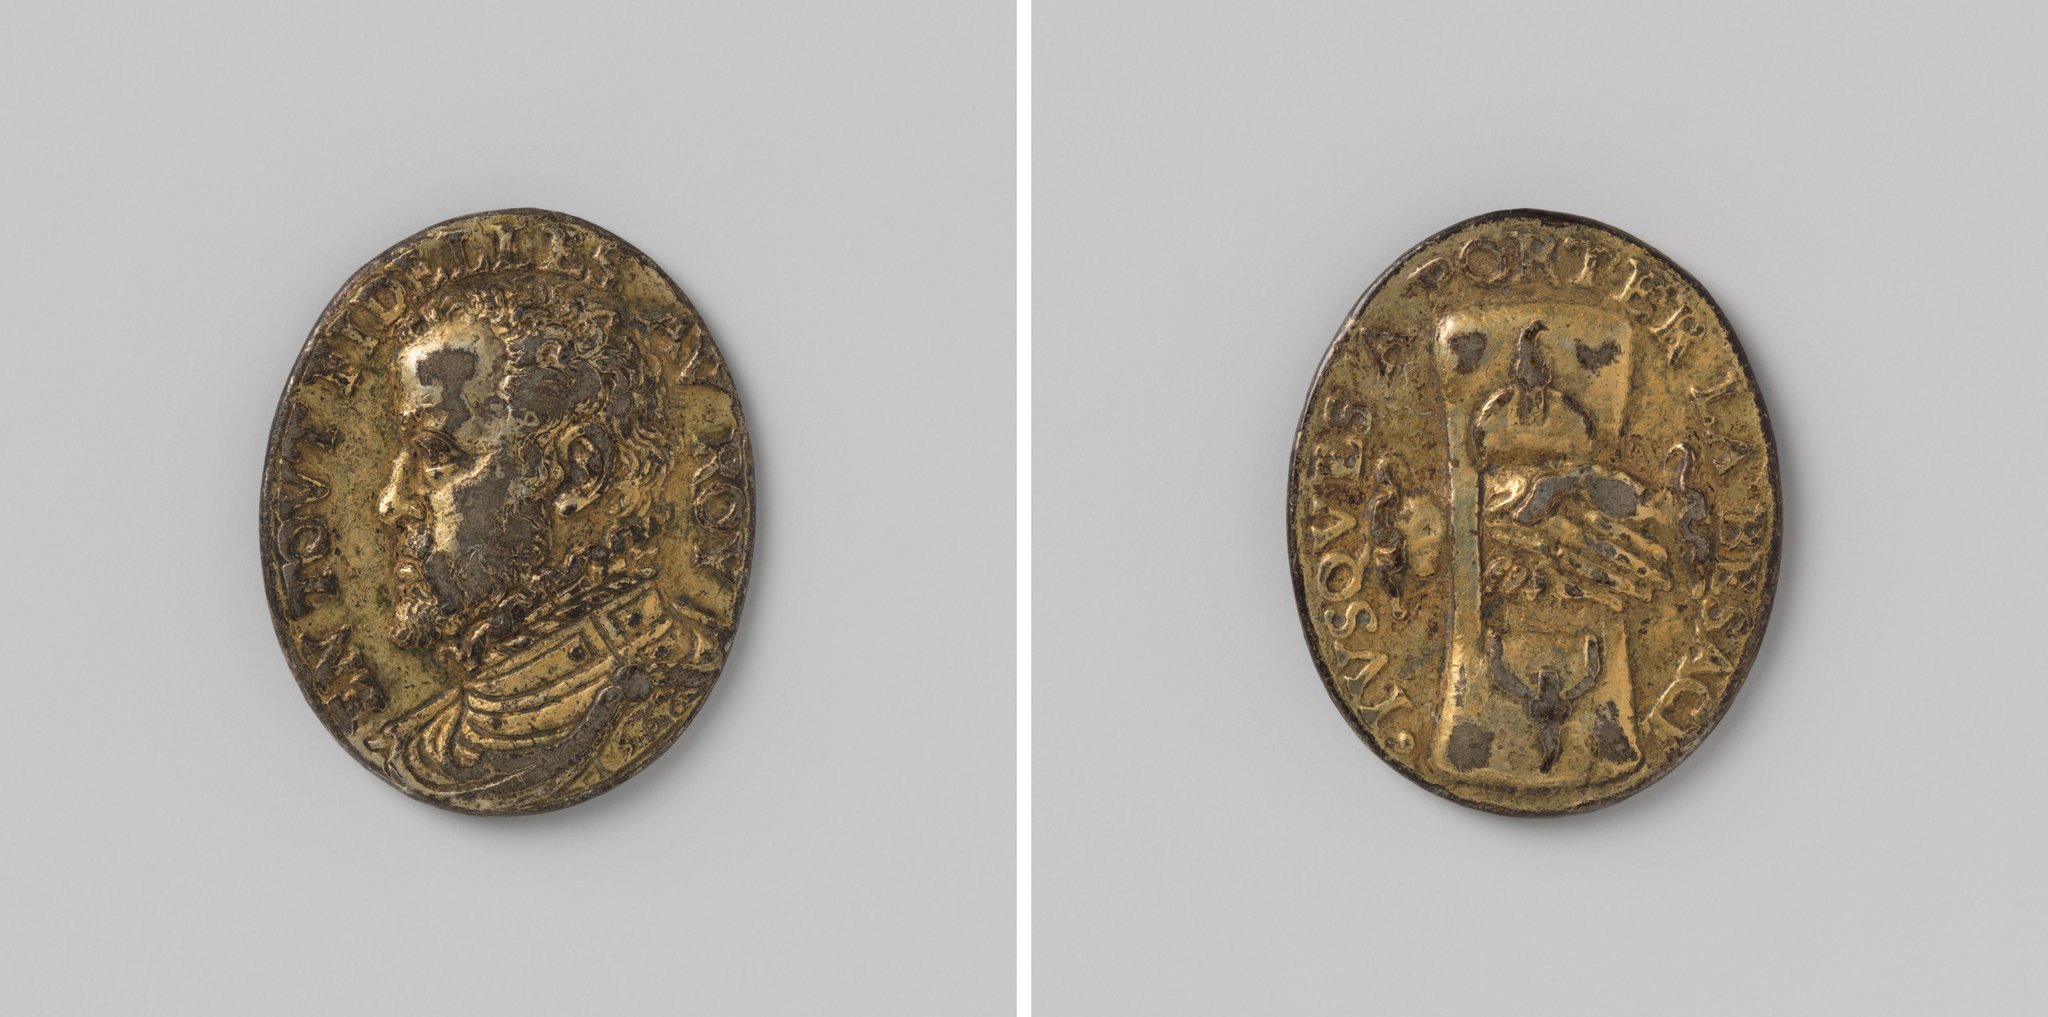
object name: insignia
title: Watergeuzen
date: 1566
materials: silver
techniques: casting, gilding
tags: philip ii of spain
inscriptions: circumscription: ‘EN TOVT FIDELLES AV ROY’, circumscription: ‘IVSQVES A PORTER LA BESACE’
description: Zilveren ovale penning. Voorzijde: borststuk man binnen omschrift. Keerzijde: twee ineen geslagen handen door een bedelzak gestoken binnen omschrift.